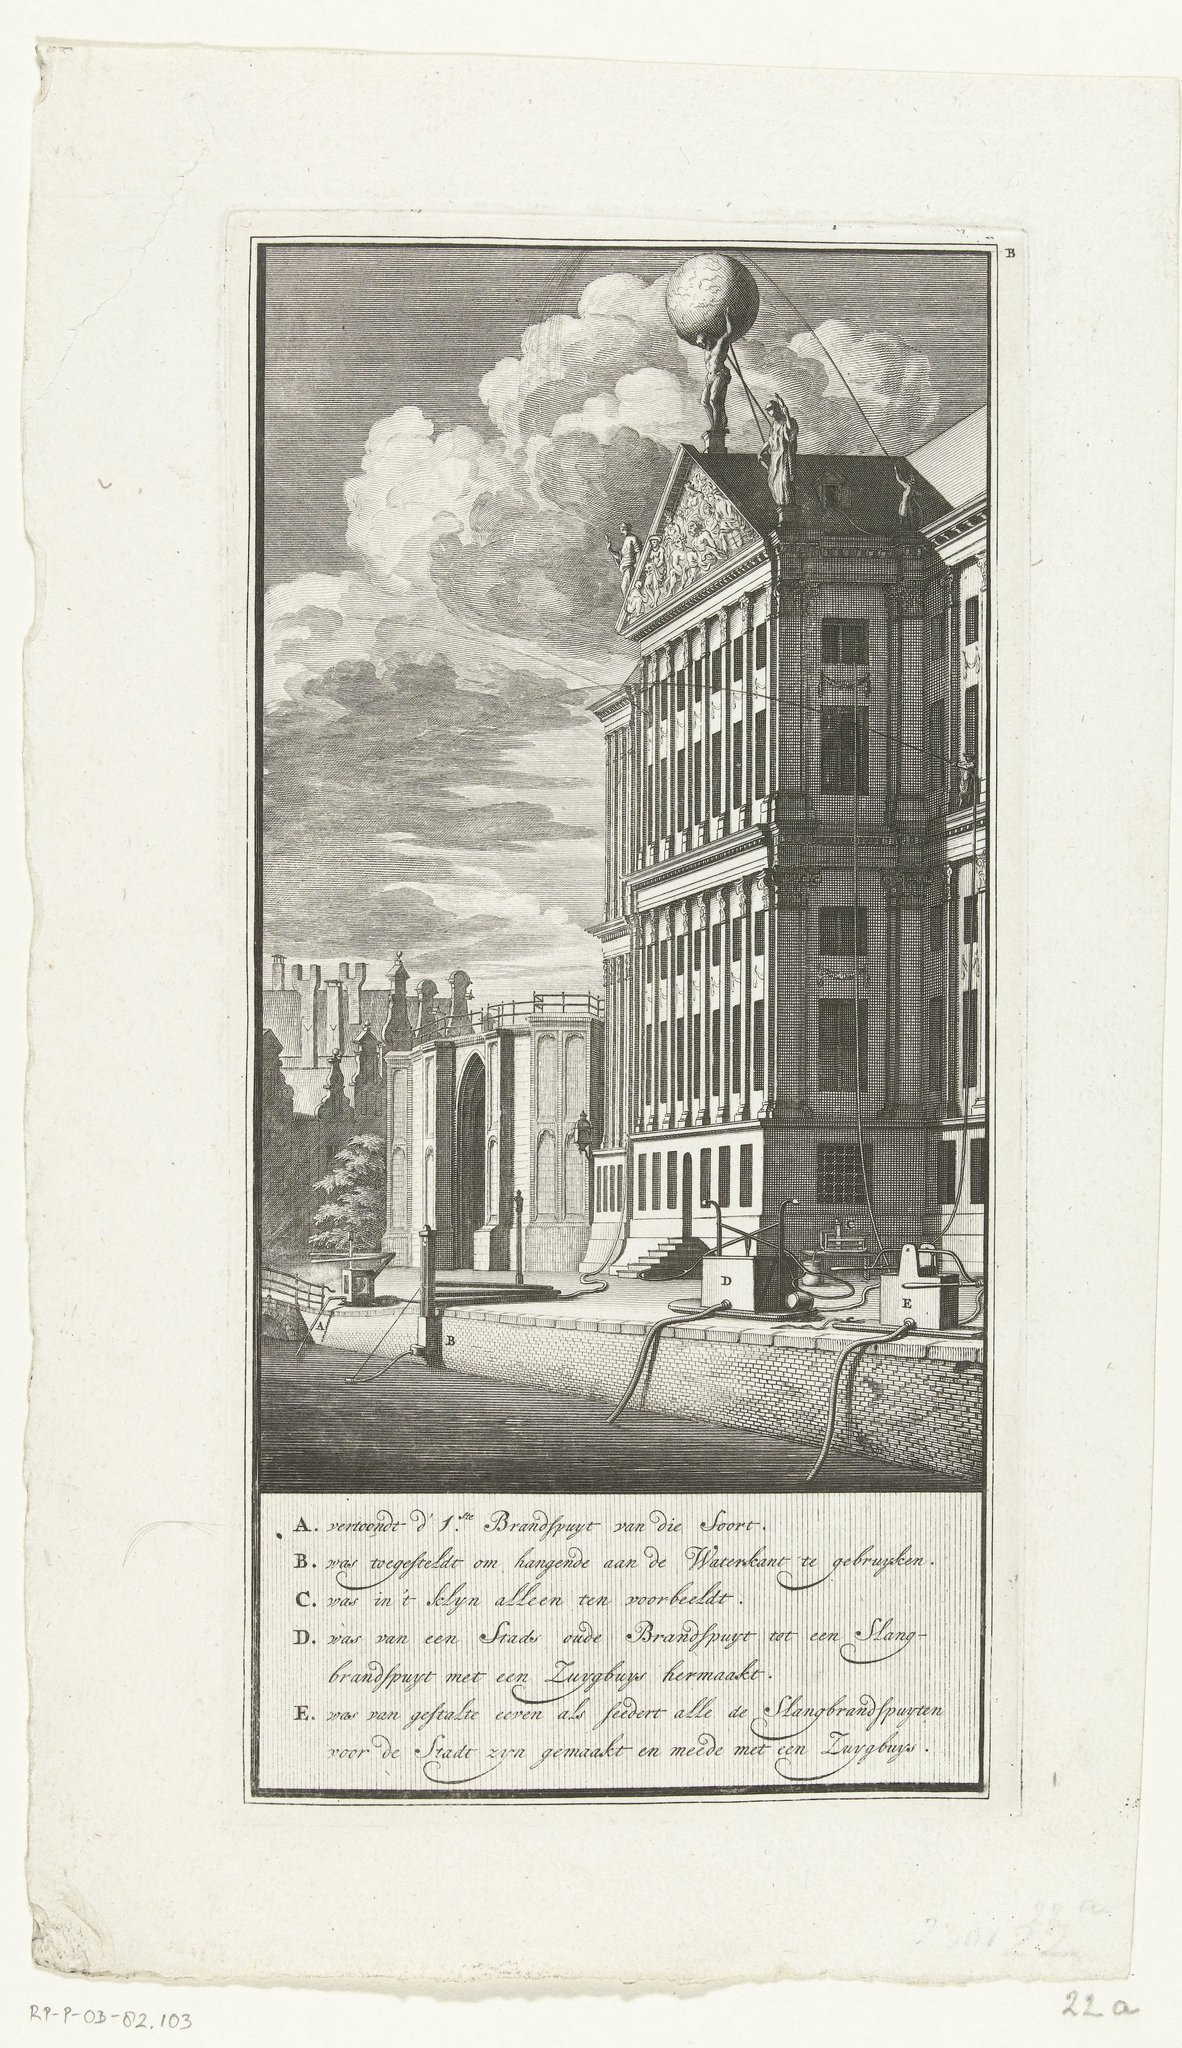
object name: print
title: Demonstratie van de slangbrandspuiten aan het water van de Nieuwezijds Voorburgwal achter het Stadhuis, 1672-1673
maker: laurens scherm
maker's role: draughtsman, print maker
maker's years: 1671-1702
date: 1690-1702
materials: paper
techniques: engraving, etching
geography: amsterdam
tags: painter, print maker, draughtsman, jan van der heyden, townhall, pump (fire-extinguishing equipment)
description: Demonstratie van het gebruik van de slangbrandspuiten door het oppompen van het water uit de Nieuwezijds Voorburgwal en over het Stadhuis heen te spuiten (1672-1673). In het onderschrift de verklaring van de letters A-E in het Nederlands. Plaat 22 in de herdruk van het Brandspuitenboek van Jan van der Heyden uit 1735.